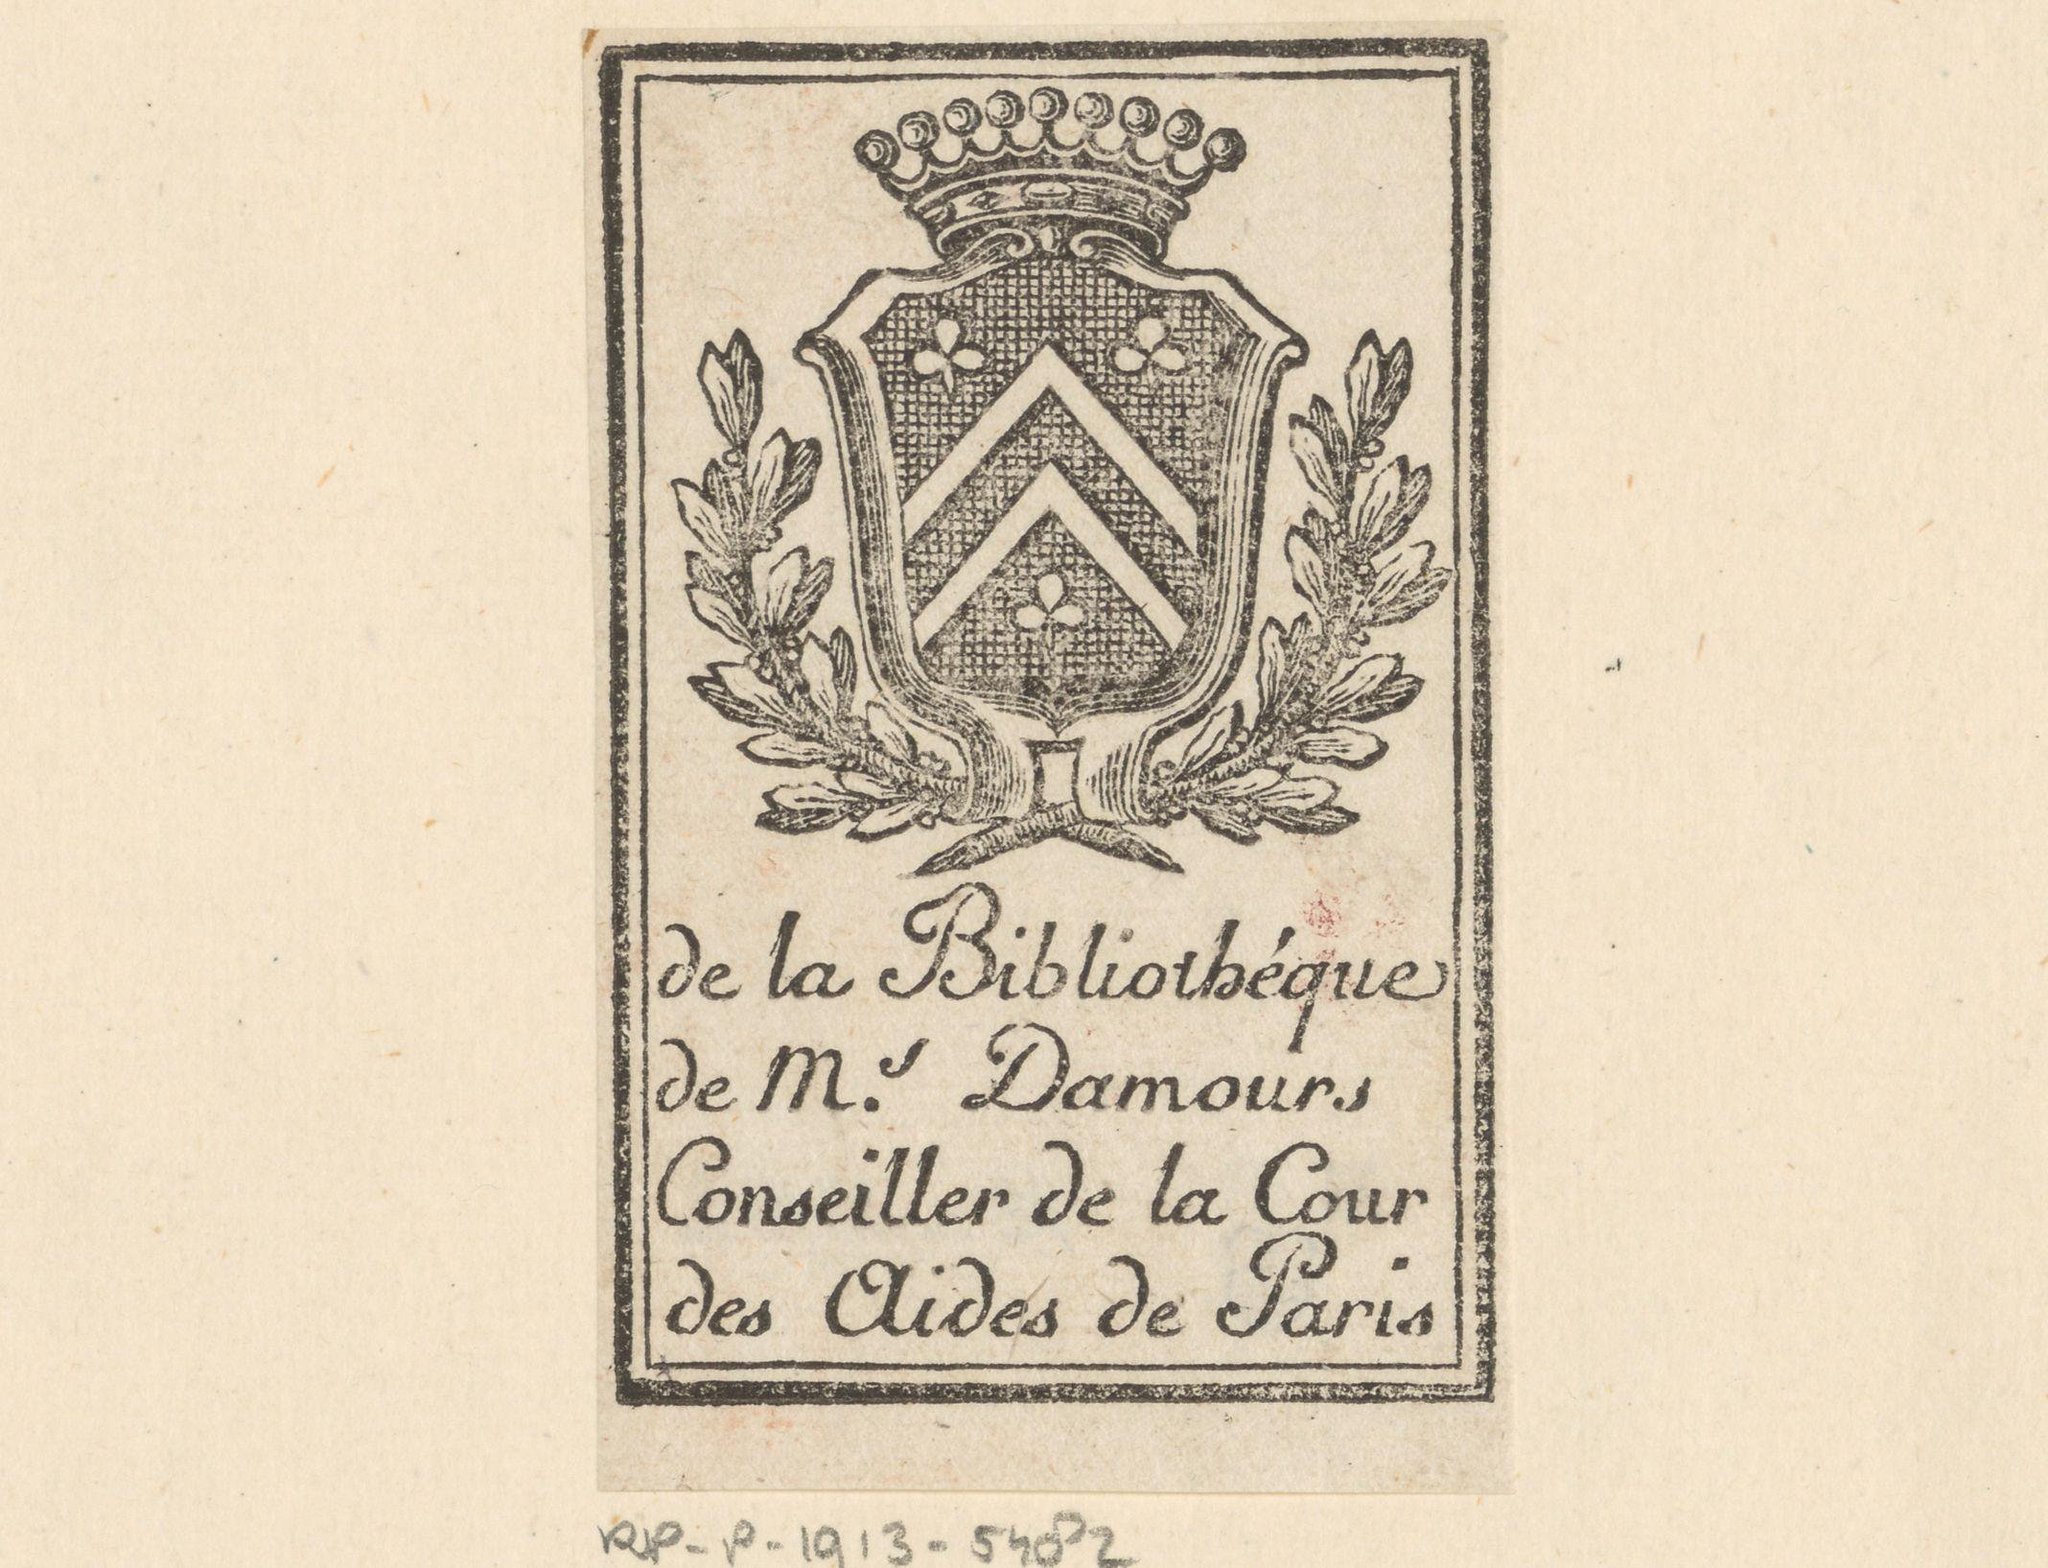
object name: bookplate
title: De la bibliothèque de Ms. Damours Consseiller de la Cour des Aides de Paris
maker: Anonymous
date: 1600-1749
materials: paper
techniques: woodcut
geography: france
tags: armorial bearing, heraldry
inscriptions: collector's mark: Lugt 2233, collector's mark: Lugt 2760